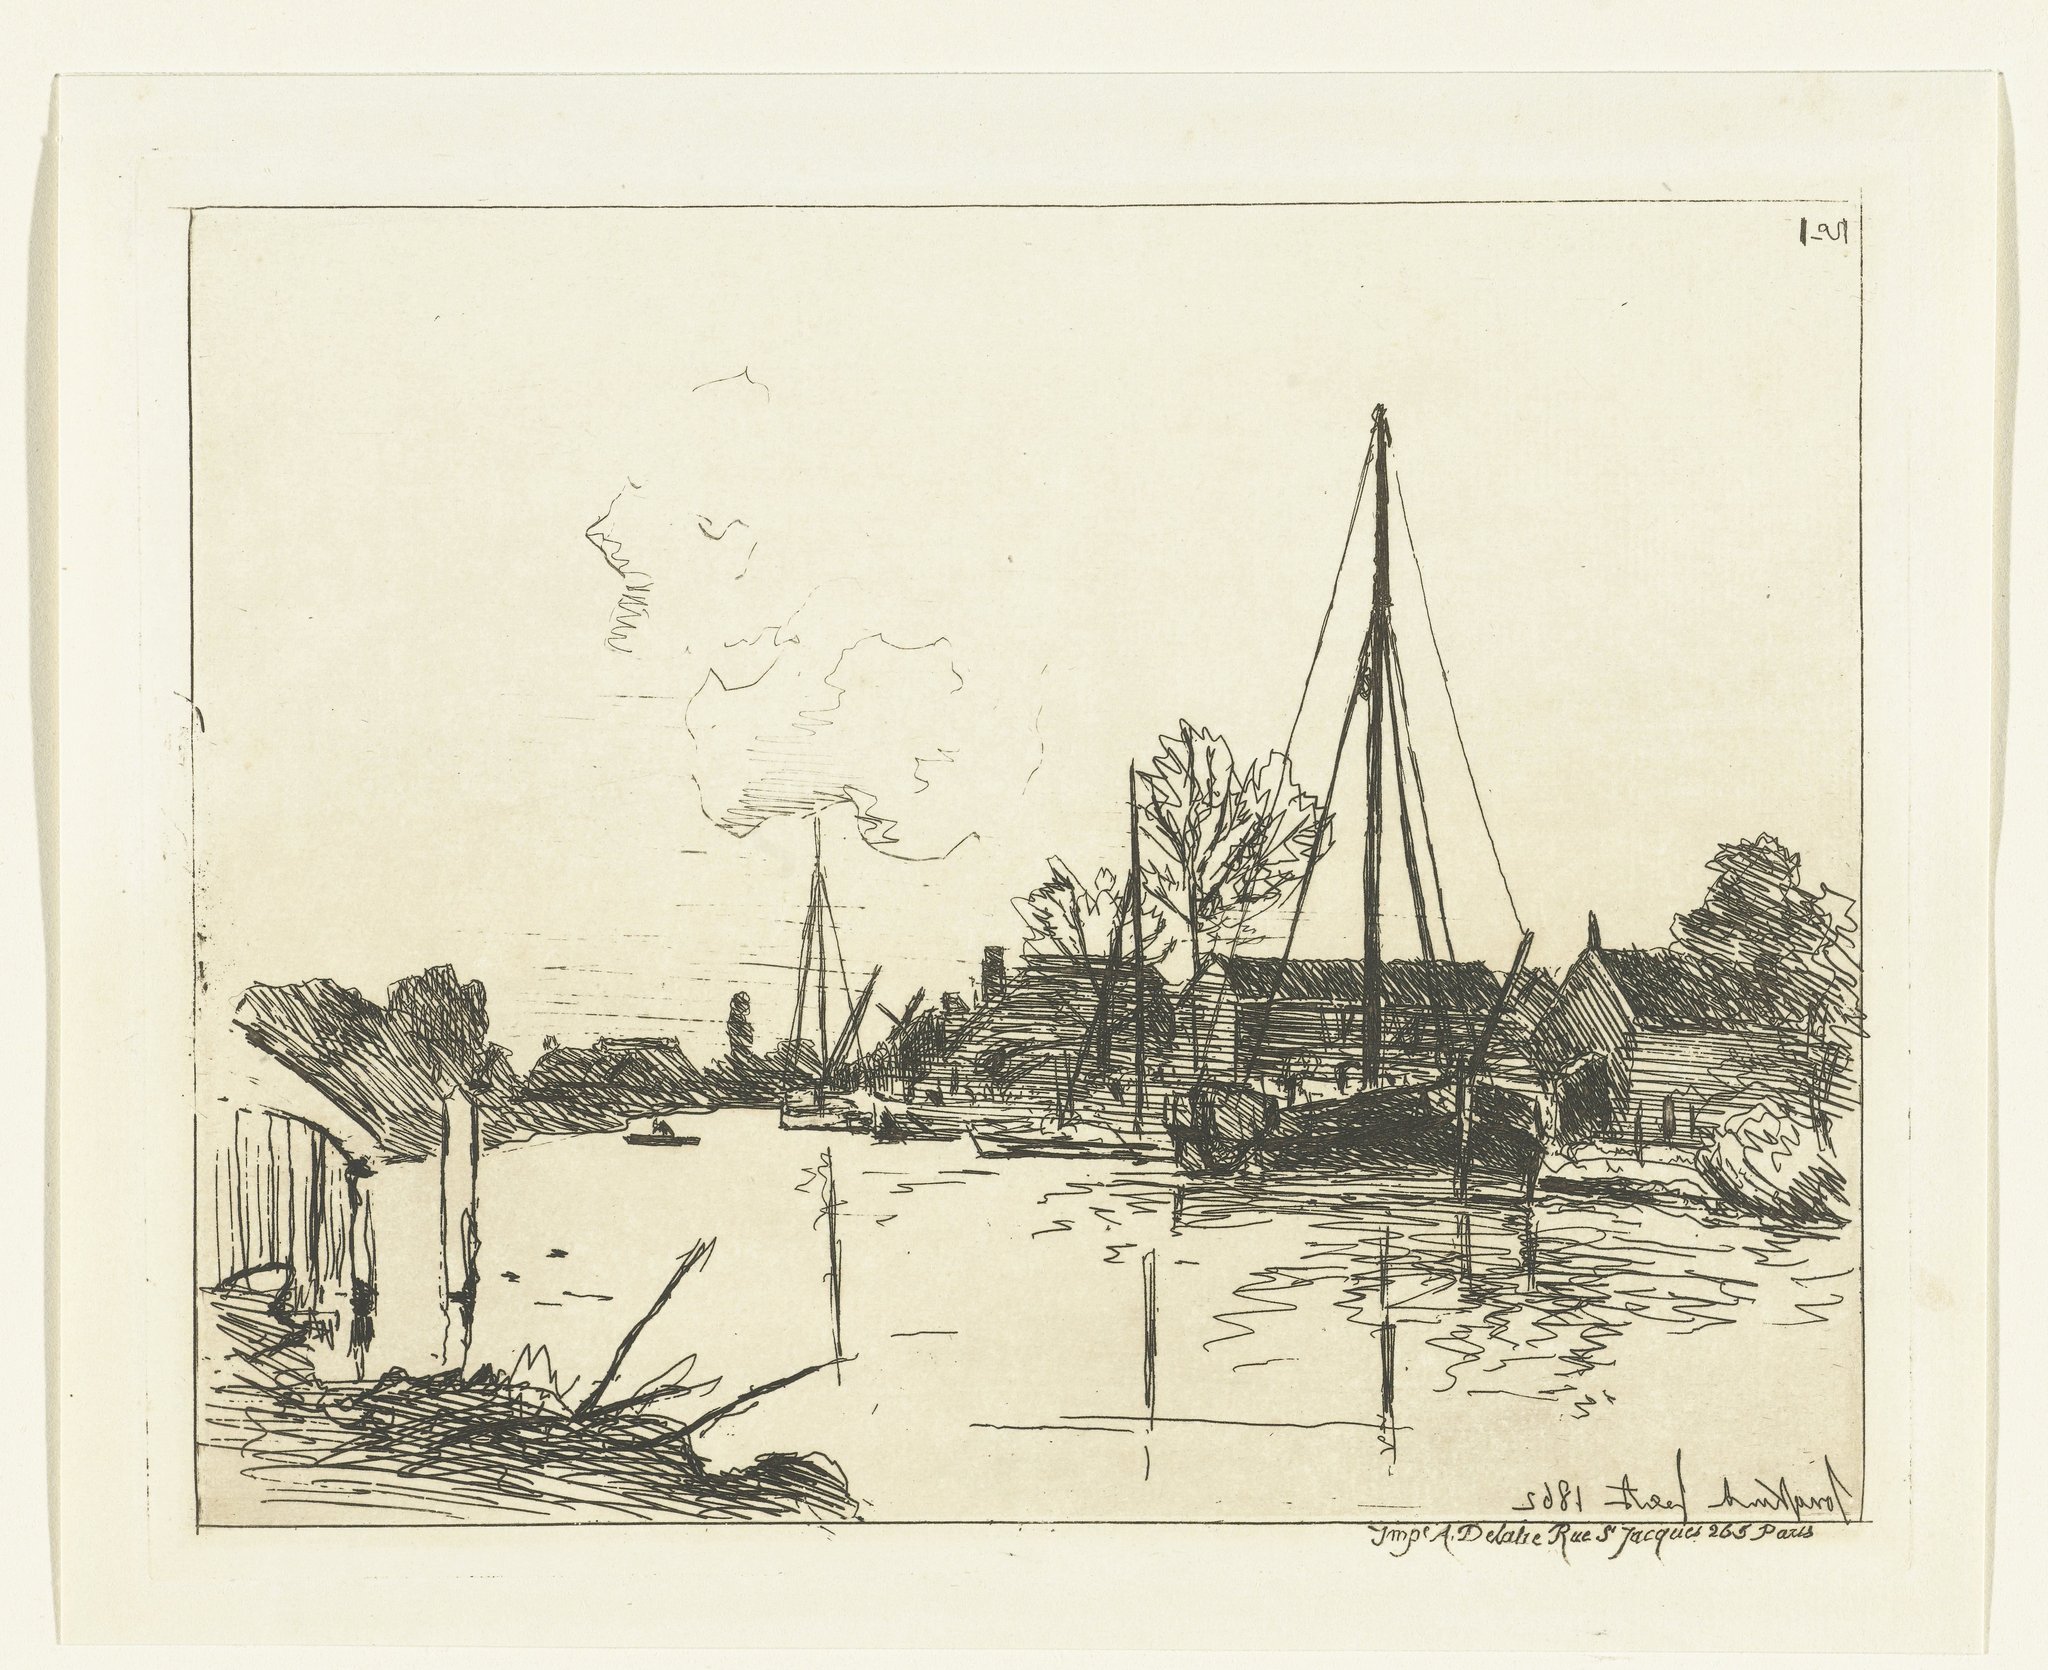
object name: print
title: De vaart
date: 1862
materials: paper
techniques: etching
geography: paris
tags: landscapes in the temperate zone, ships (in general), water course, holland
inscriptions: collector's mark: Lugt 2228a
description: Gezicht op een brede vaart, waaraan enkele gebouwen staan. Langs de waterkant liggen boten. Deze prent is onderdeel van een serie van zes geëtste Hollandse gezichten (de eerste twee genummerd), het geheel voorafgegaan door een titelblad.